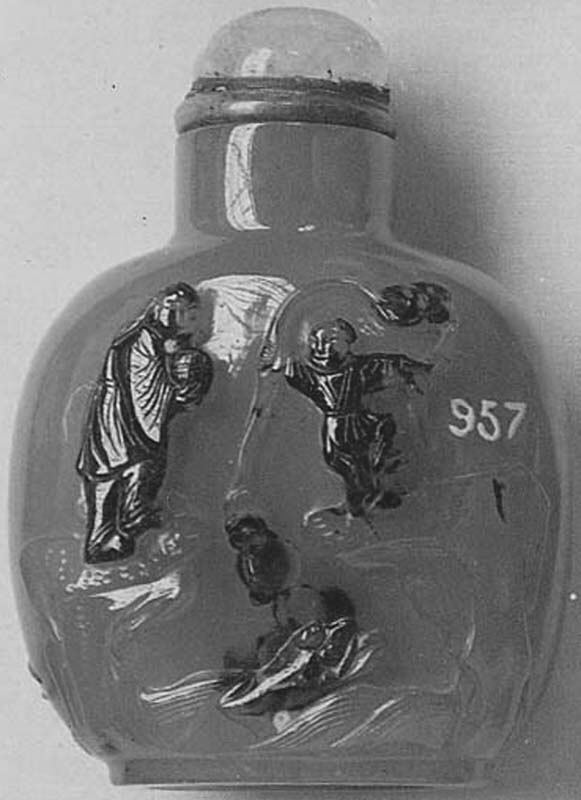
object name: snuff bottle with stopper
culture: chinese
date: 1701-1900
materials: stone, gemstone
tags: human figures